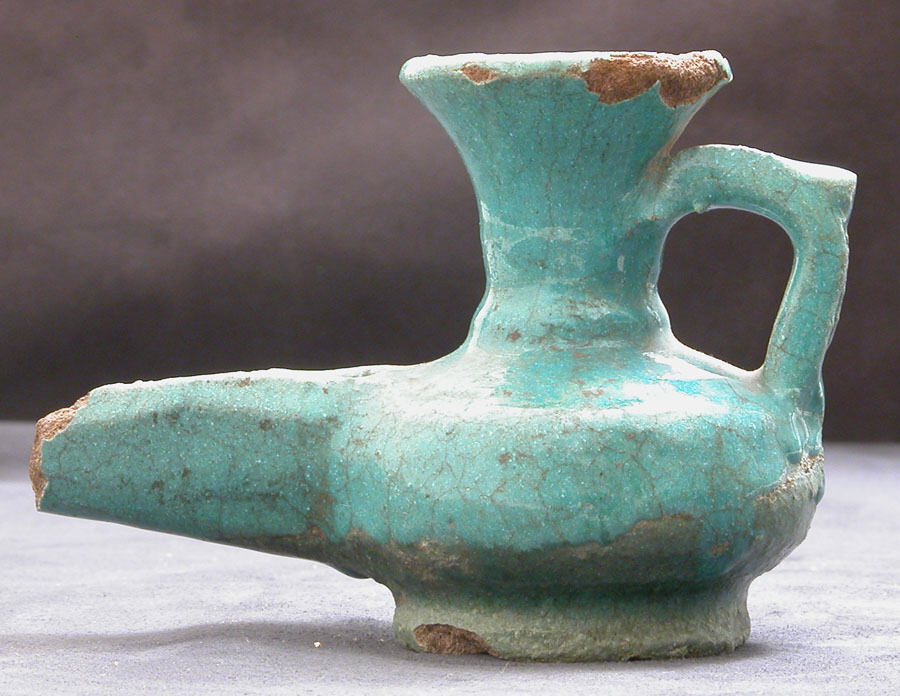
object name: lamp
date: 1101-1300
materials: earthenware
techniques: glazing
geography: syria